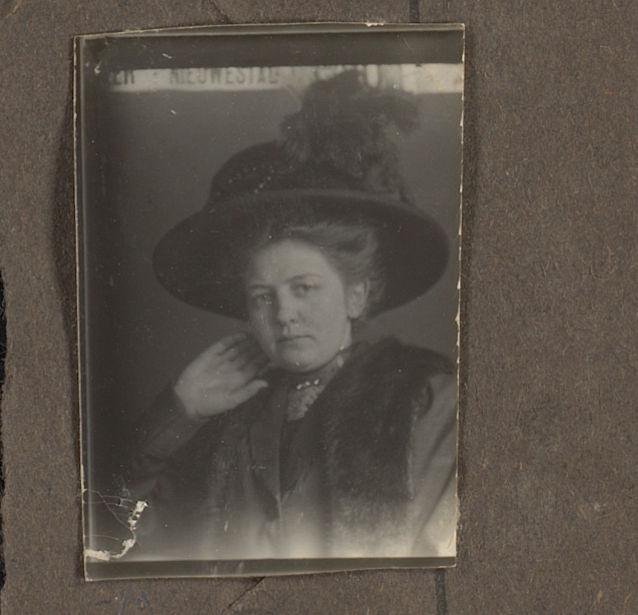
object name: album leaf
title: Portret van een onbekende jonge vrouw met hoed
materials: paper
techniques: gelatin silver print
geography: leeuwarden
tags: anonymous historical person portrayed - bb - woman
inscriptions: inscription: ‘EER [...]’